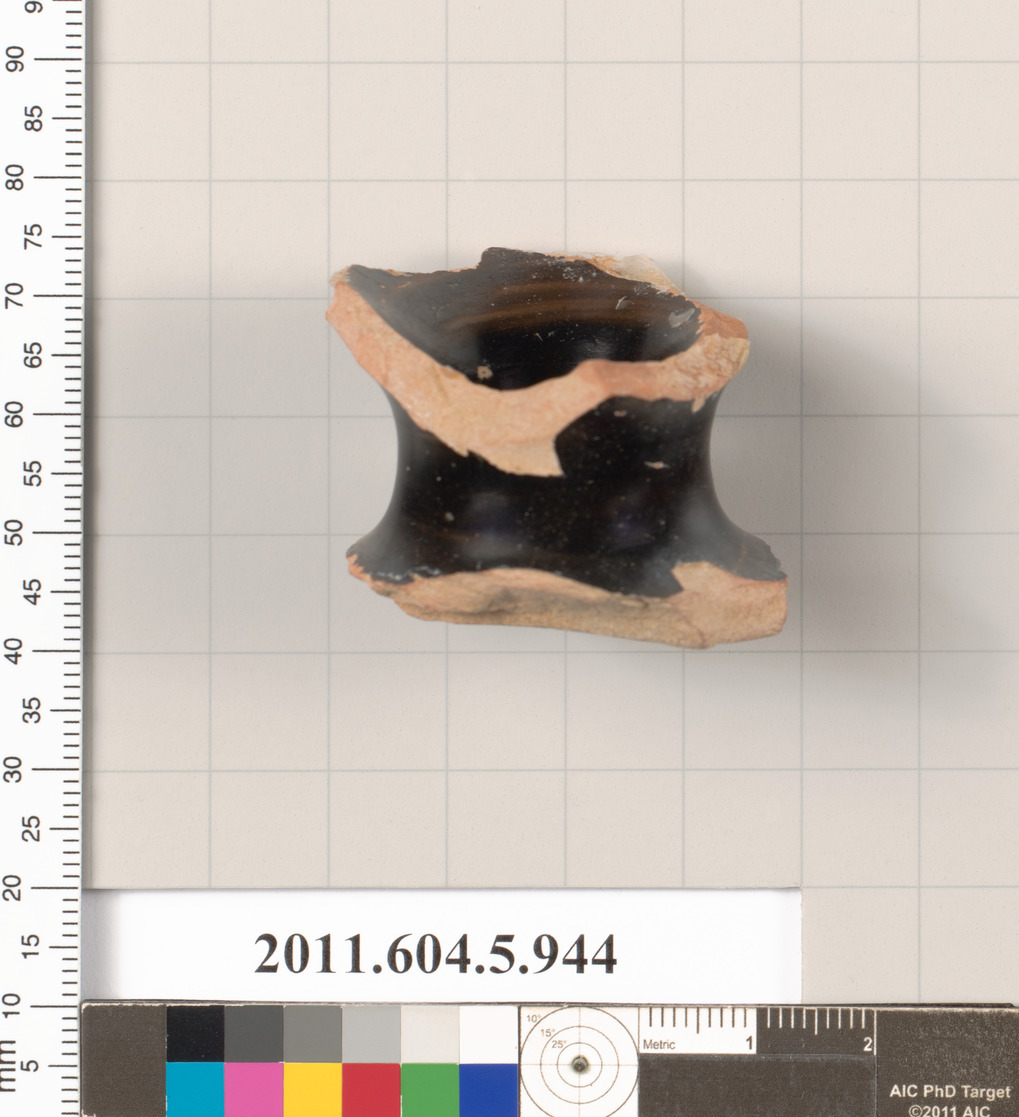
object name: kylix fragment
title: Terracotta fragment of a kylix (drinking cup)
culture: greek, attic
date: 600-401 BCE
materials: terracotta